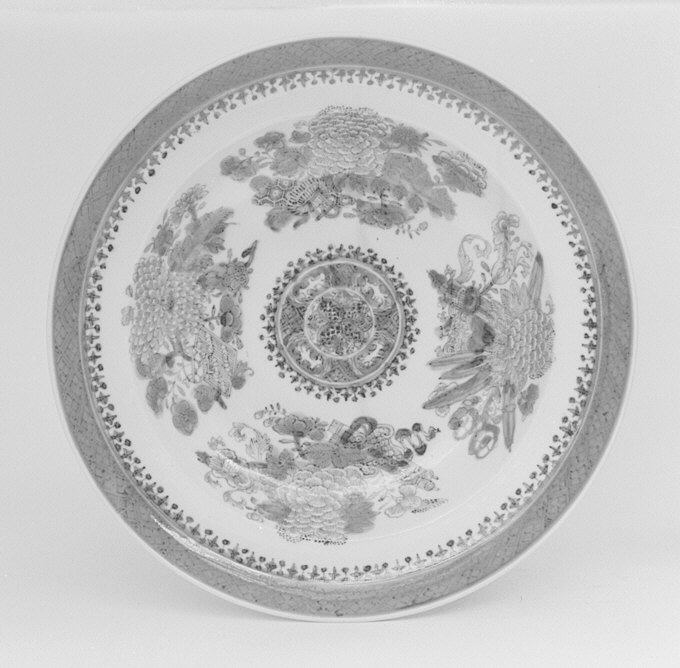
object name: soup plate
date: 1801-1833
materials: hard paste porcelain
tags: flowers